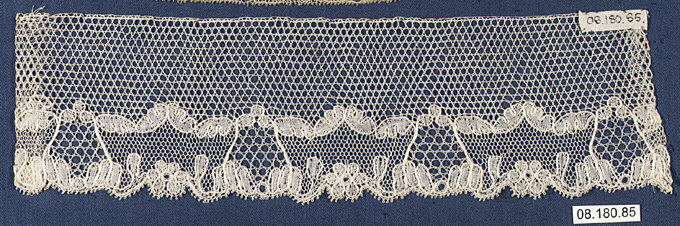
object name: fragment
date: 1801-1900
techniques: lace